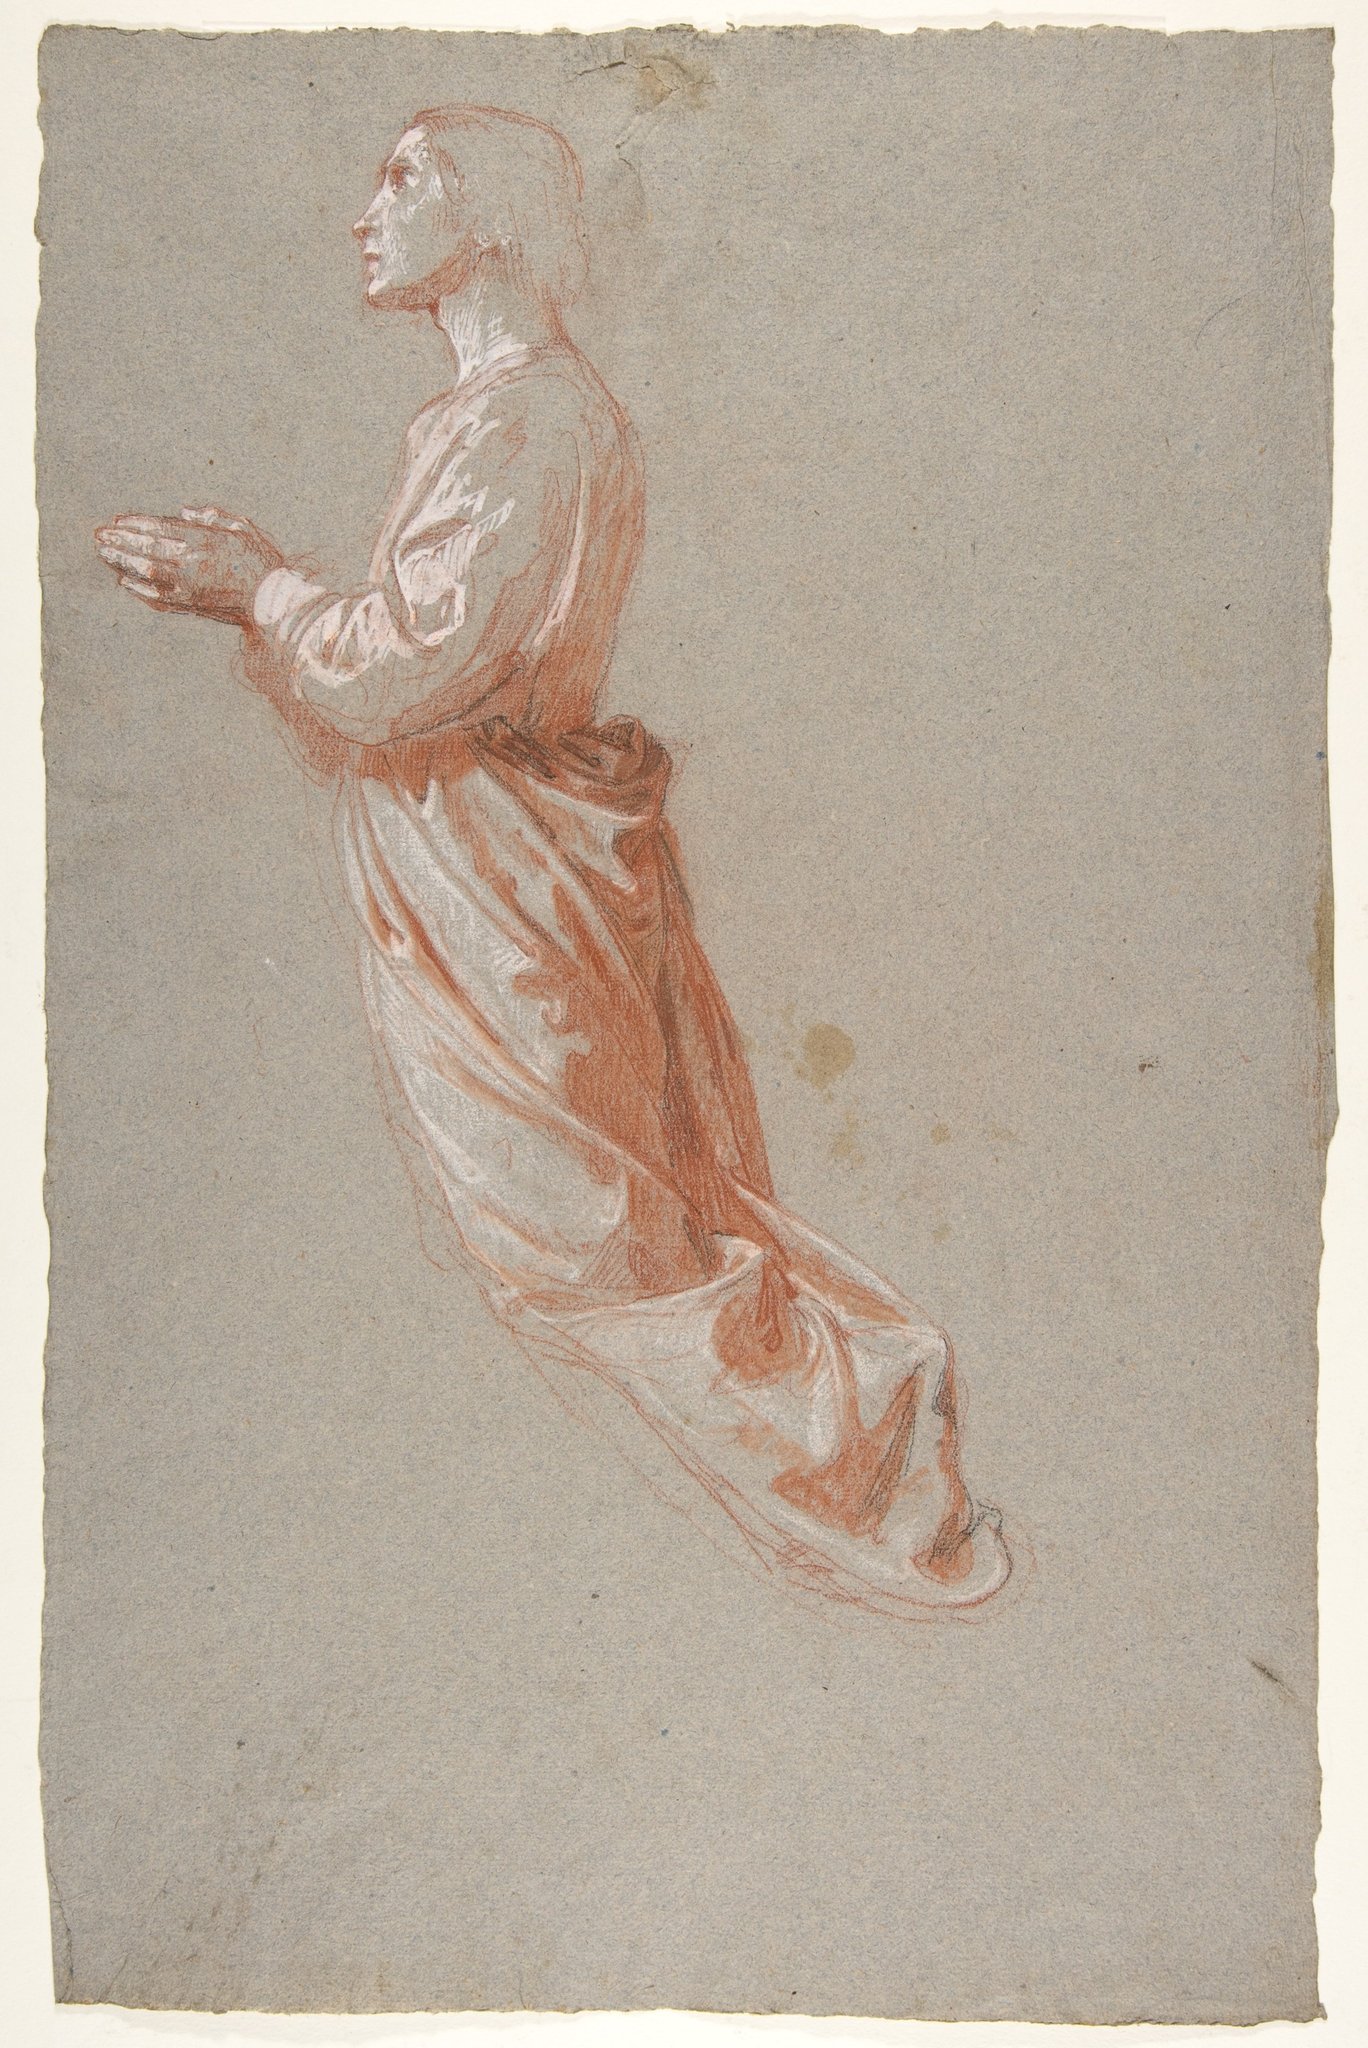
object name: drawing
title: Angel (upper register; study for wall paintings in the Chapel of Saint Remi, Sainte-Clotilde, Paris, 1858)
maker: isidore pils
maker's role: artist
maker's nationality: french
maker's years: 1813-1875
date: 1801-1900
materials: chalk, gouache, paper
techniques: heightening, stumping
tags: angels